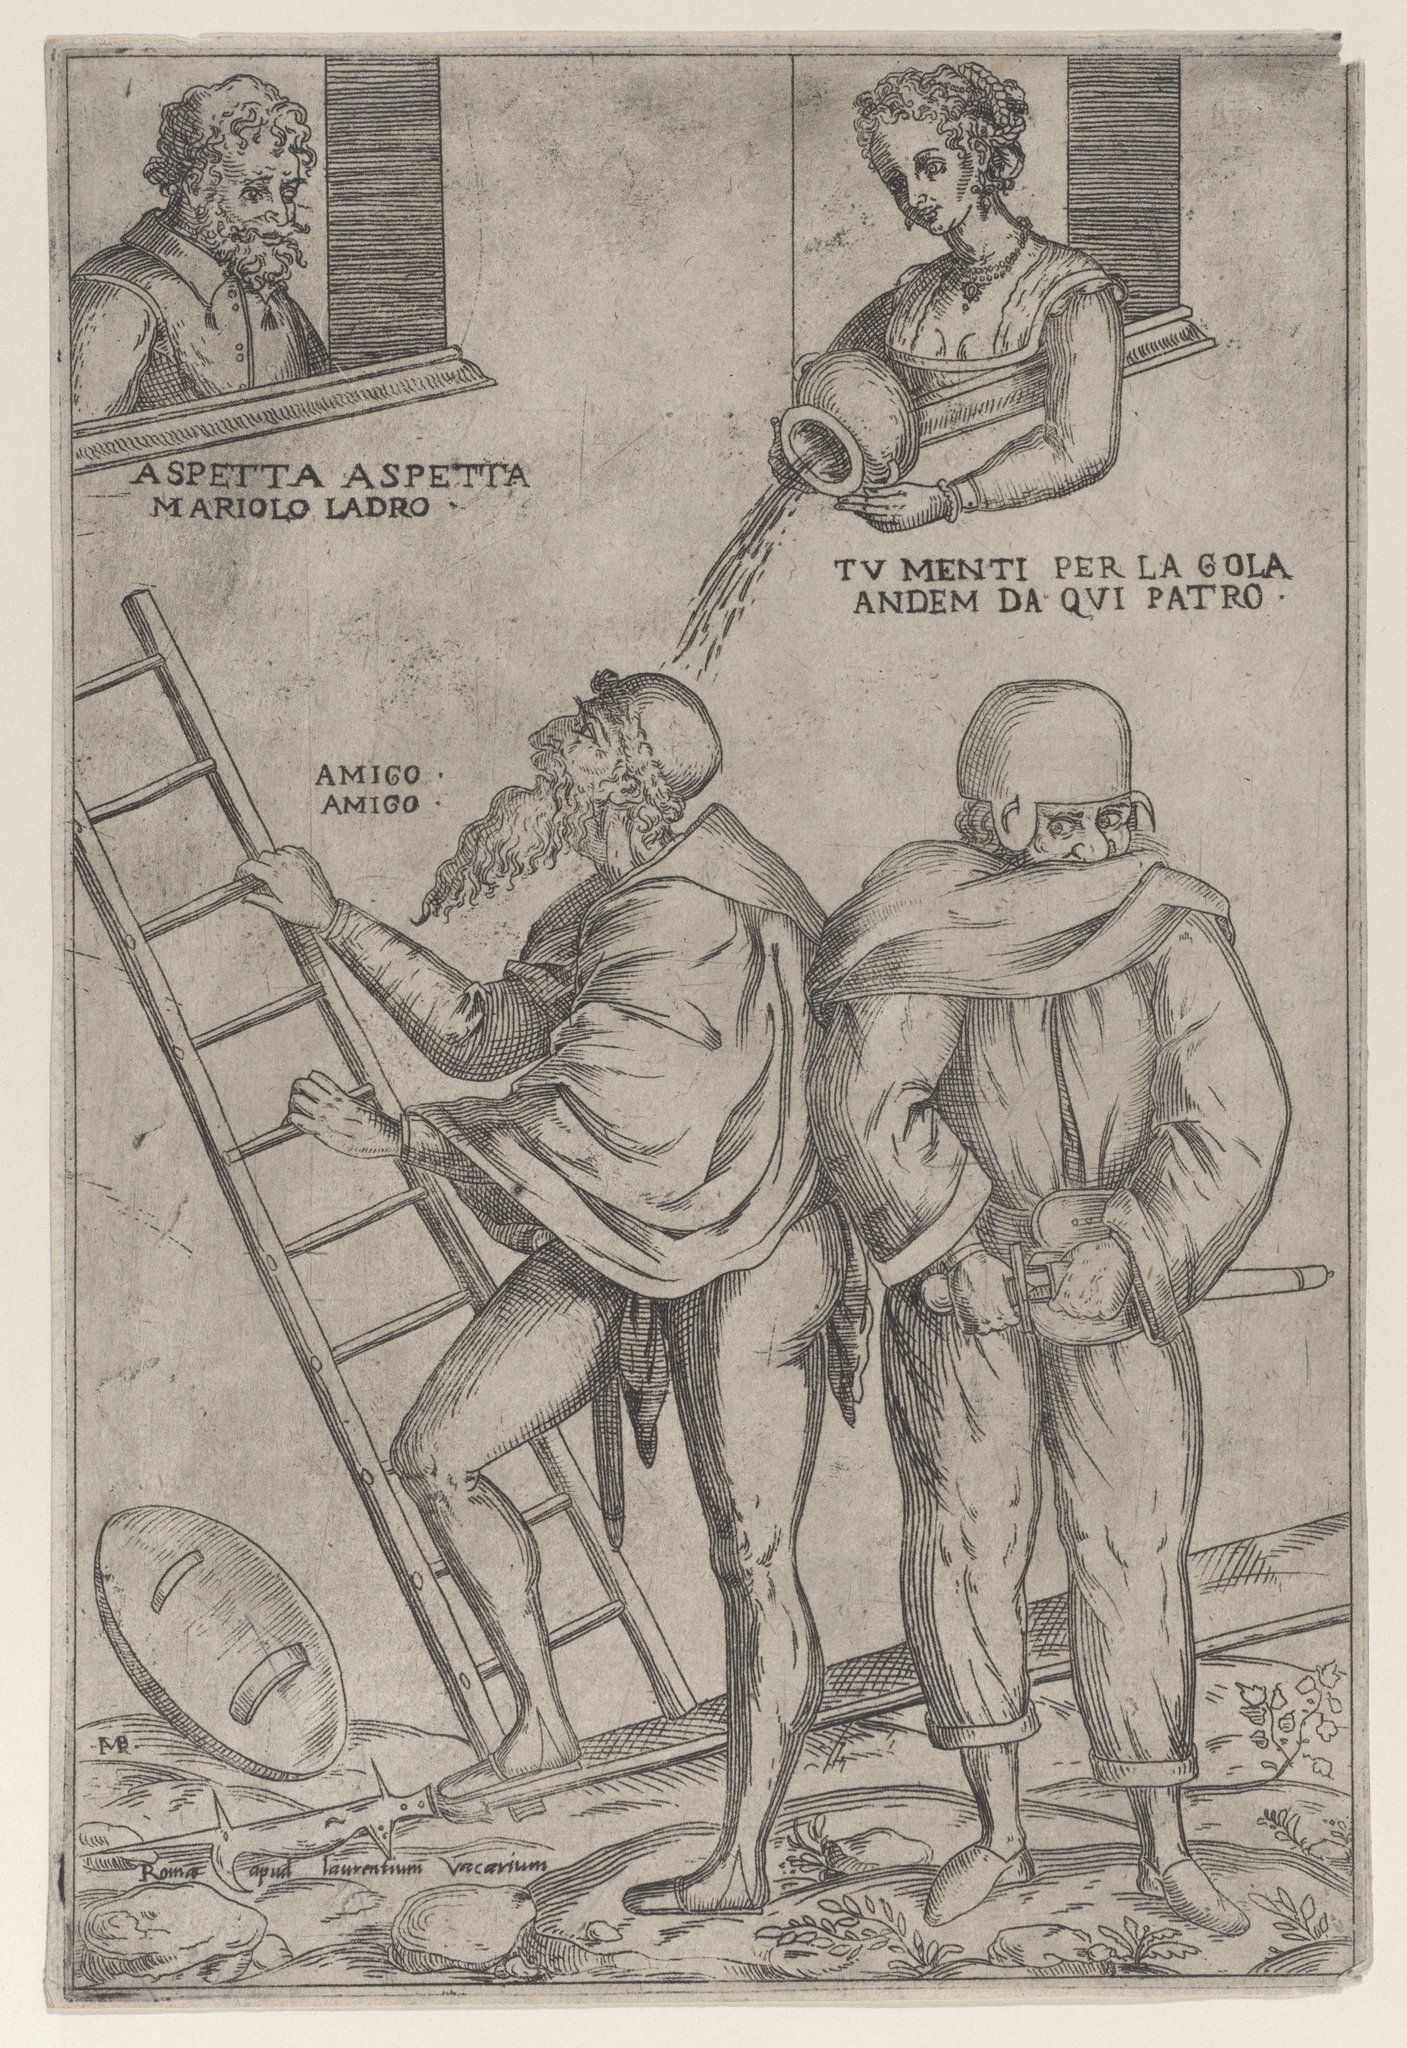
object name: print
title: A man climbs a ladder while a woman throws water on him from above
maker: giovanni ambrogio brambilla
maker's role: artist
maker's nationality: italian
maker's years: 1575-1599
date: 1575-1599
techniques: engraving